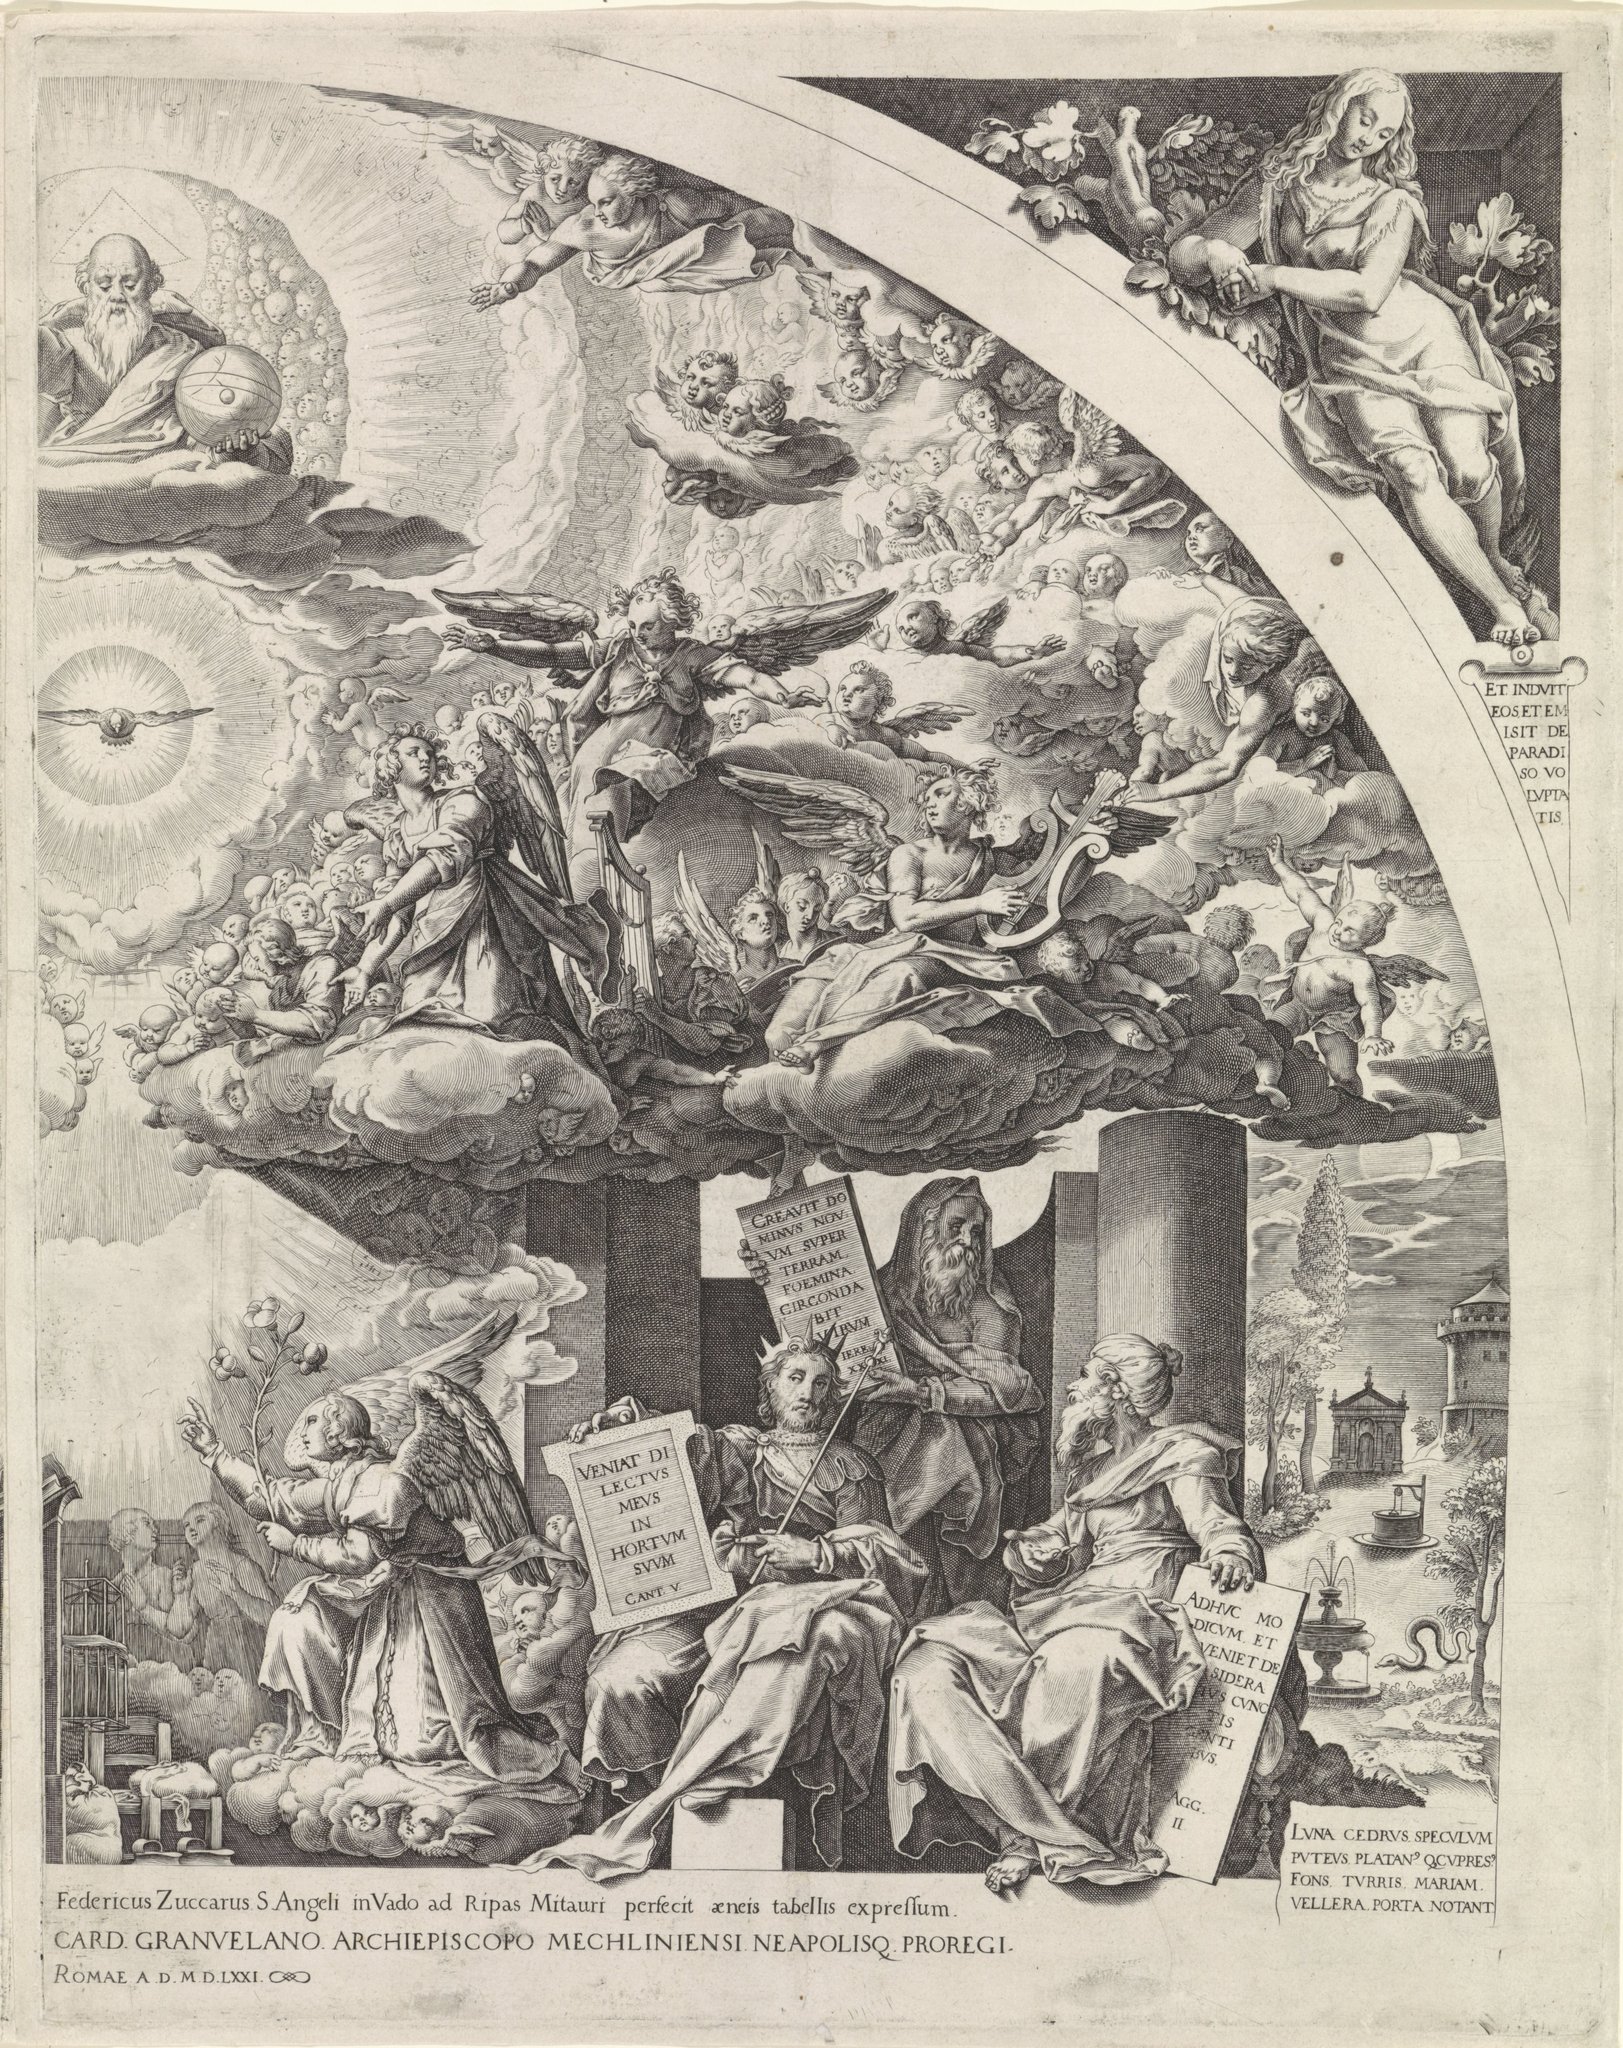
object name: print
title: Annunciatie, omgeven door profeten, rechterdeel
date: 1571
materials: paper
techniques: engraving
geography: rome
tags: the annunciation: mary kneeling, the twelve apostles ~ the twelve prophets, angels singing, making music, god the father represented as human being, usually with crown or tiara or sceptre and/or globe, holy ghost represented as a dove (in flames)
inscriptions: collector's mark: Lugt 240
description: In het midden de geknielde Maria, met voor haar de knielende engel met een lelie in de hand. Links en rechts profeten. Boven hen engelenkoren in de wolken, in het midden in een stralenkrans, God de Vader als oude man met wereldbol en de H. Geest in de gedaante van een duif.